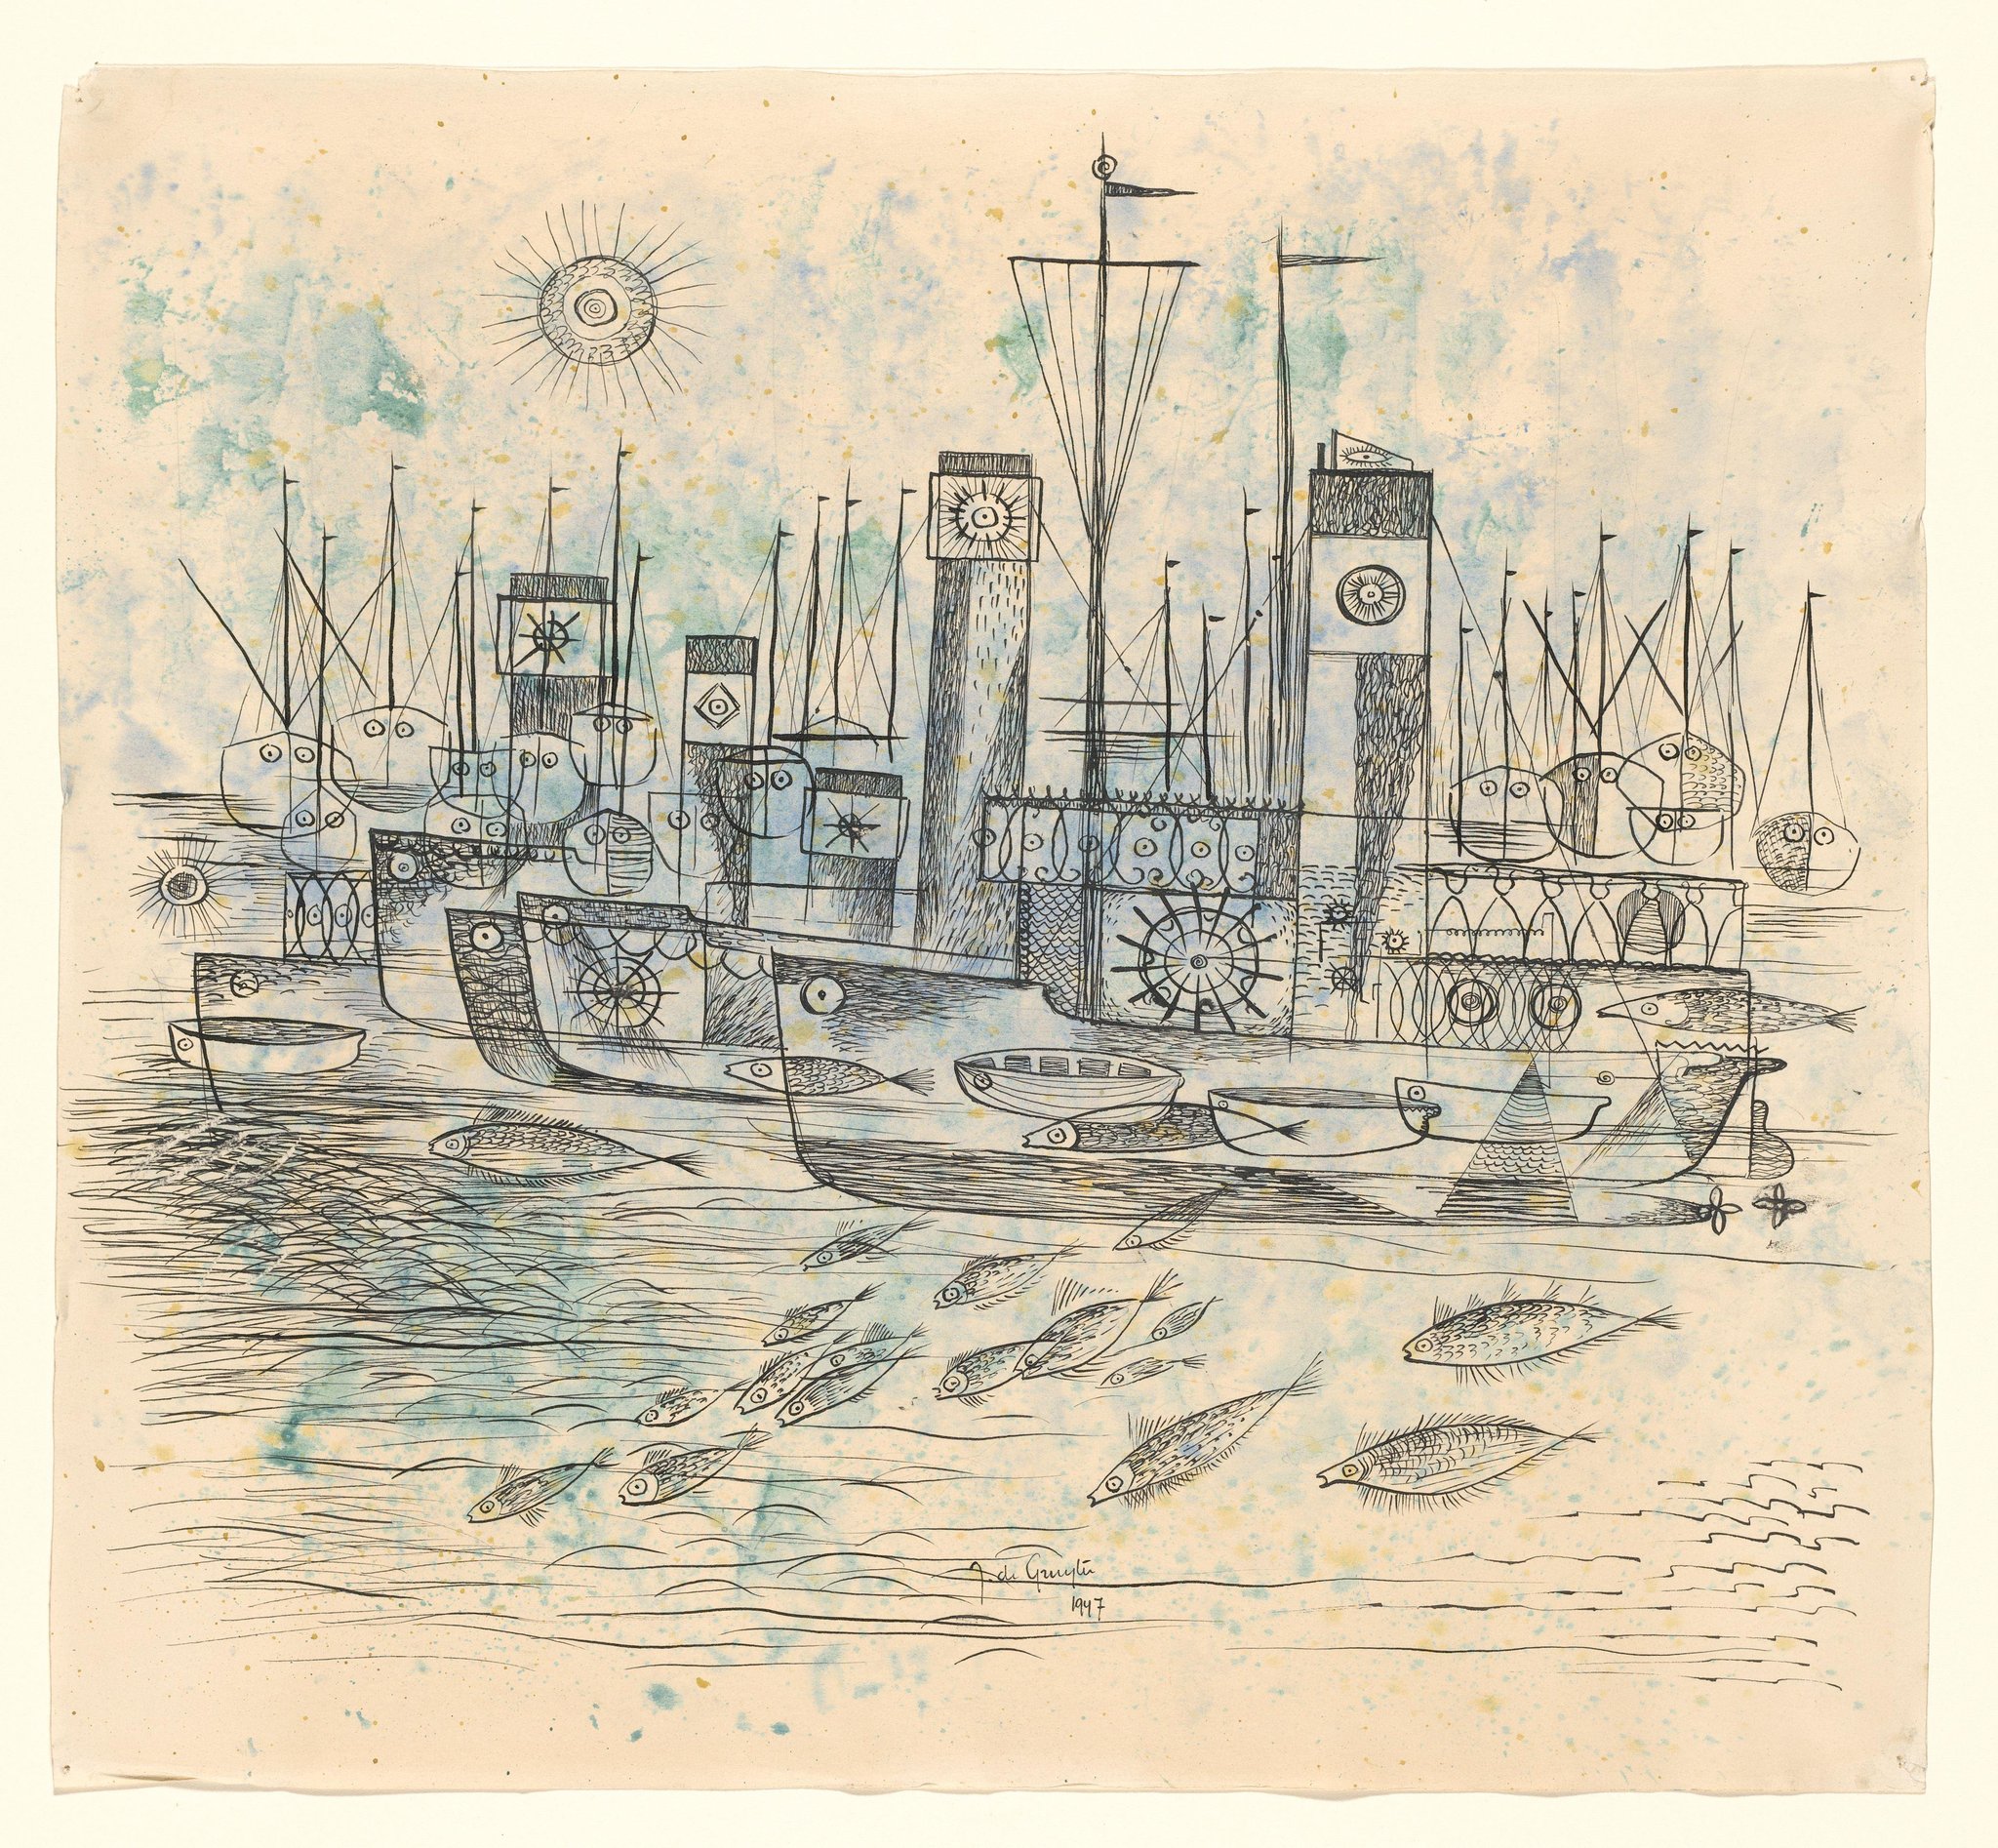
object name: drawing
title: Haven met sleepboten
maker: jan de gruijter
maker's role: draughtsman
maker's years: 1917-1951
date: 1947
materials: ink, paper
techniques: brush, pen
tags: harbour, ships (in general)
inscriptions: collector's mark: Lugt 2228